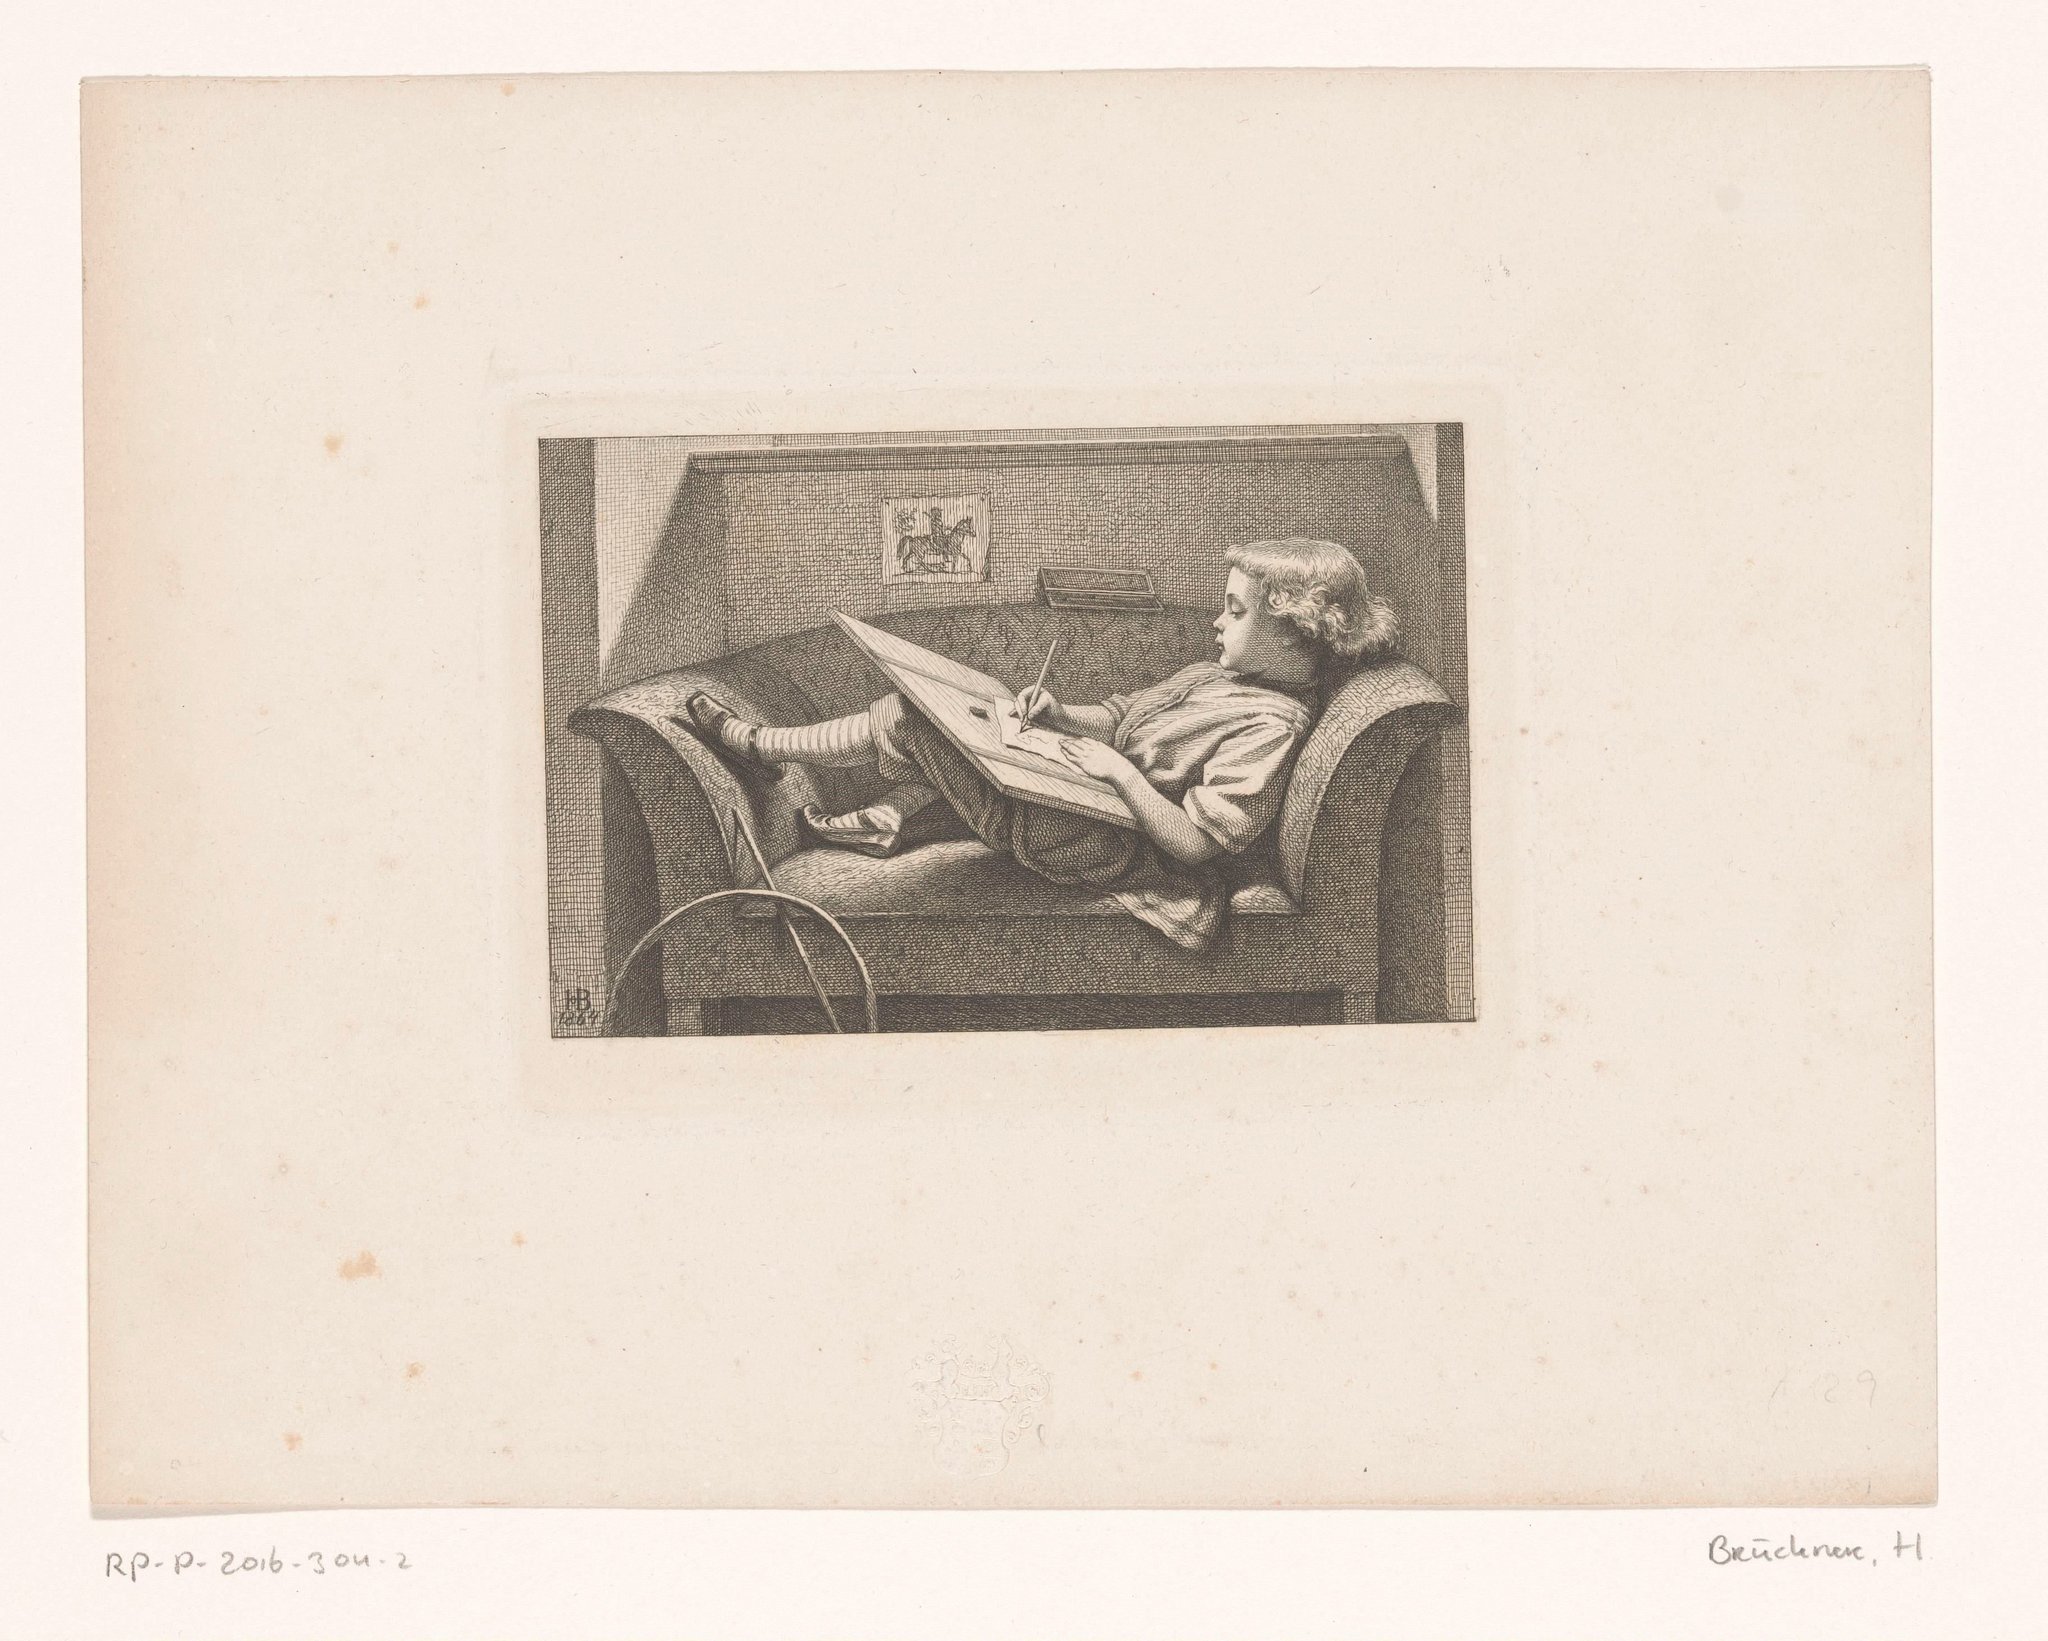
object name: print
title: De kleine tekenaar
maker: hugo bürkner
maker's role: print maker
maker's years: 1818-1897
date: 1865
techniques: printmaking, etching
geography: germany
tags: drawing, child and art, draughtsman at work, (bowling a) hoop, child (at home)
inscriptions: collector's mark: Lugt 2760, collector's mark: Lugt 2228, collector's mark: ‘wapenschild met schilddekking met twee helmen’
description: Een kind tekenend, liggend op een bank. Aan de muur een prent of tekening van een ruiter. Tegen de bank staan een hoepel en stok geleund.